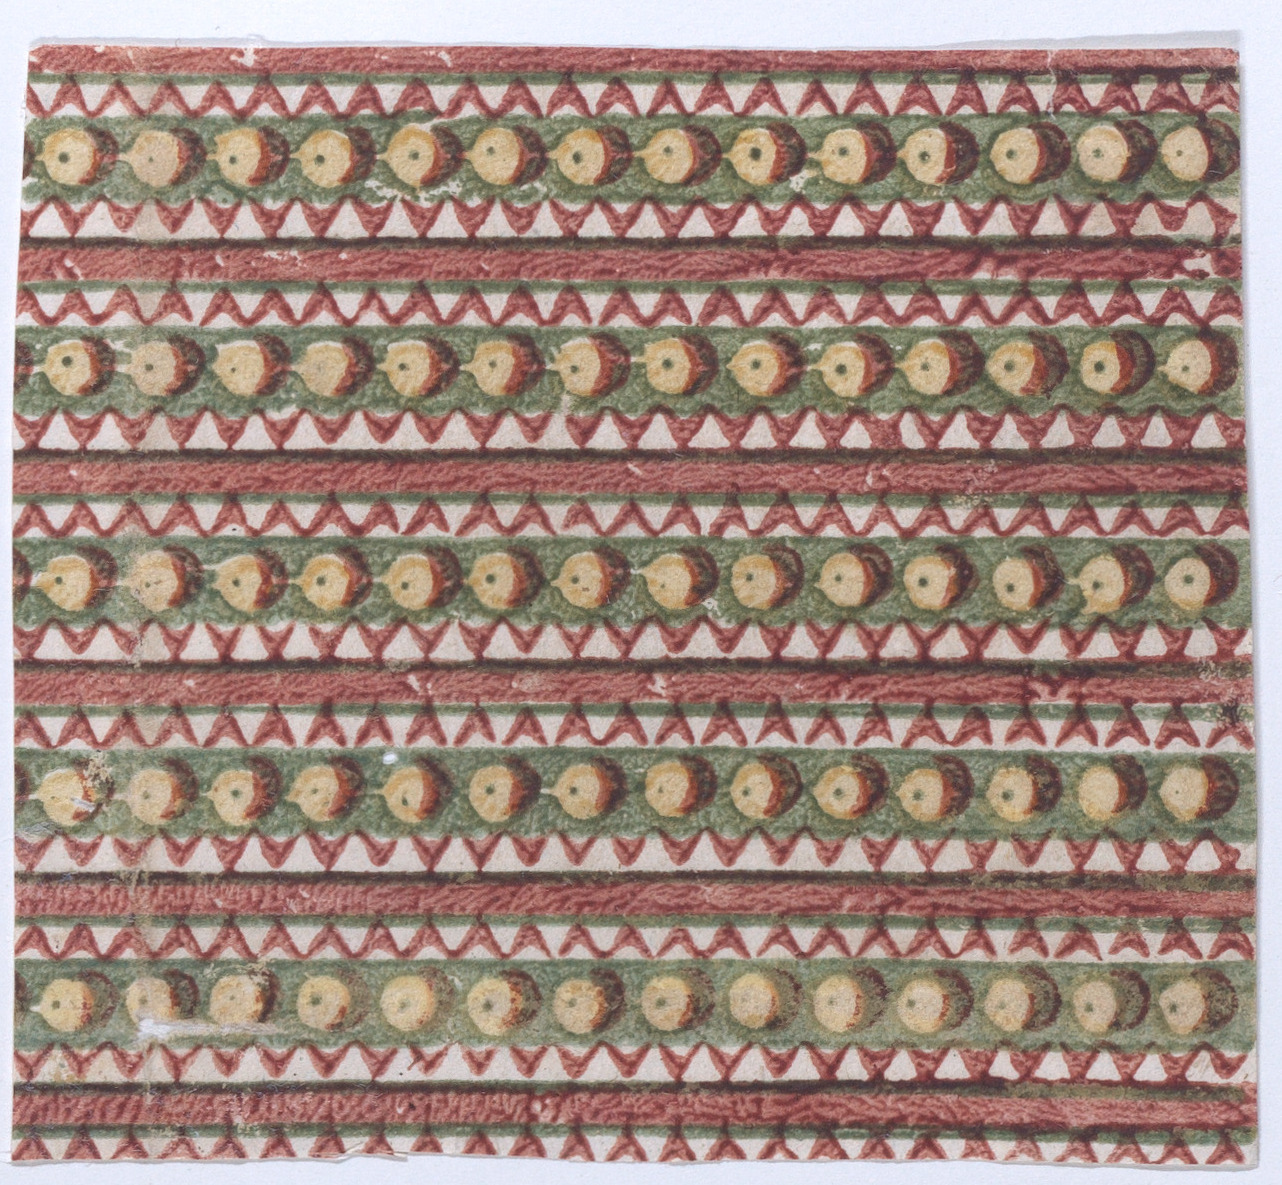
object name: print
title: Sheet with overall patterns of pearls and zigzags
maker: Anonymous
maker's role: artist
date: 1801-1900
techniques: relief print